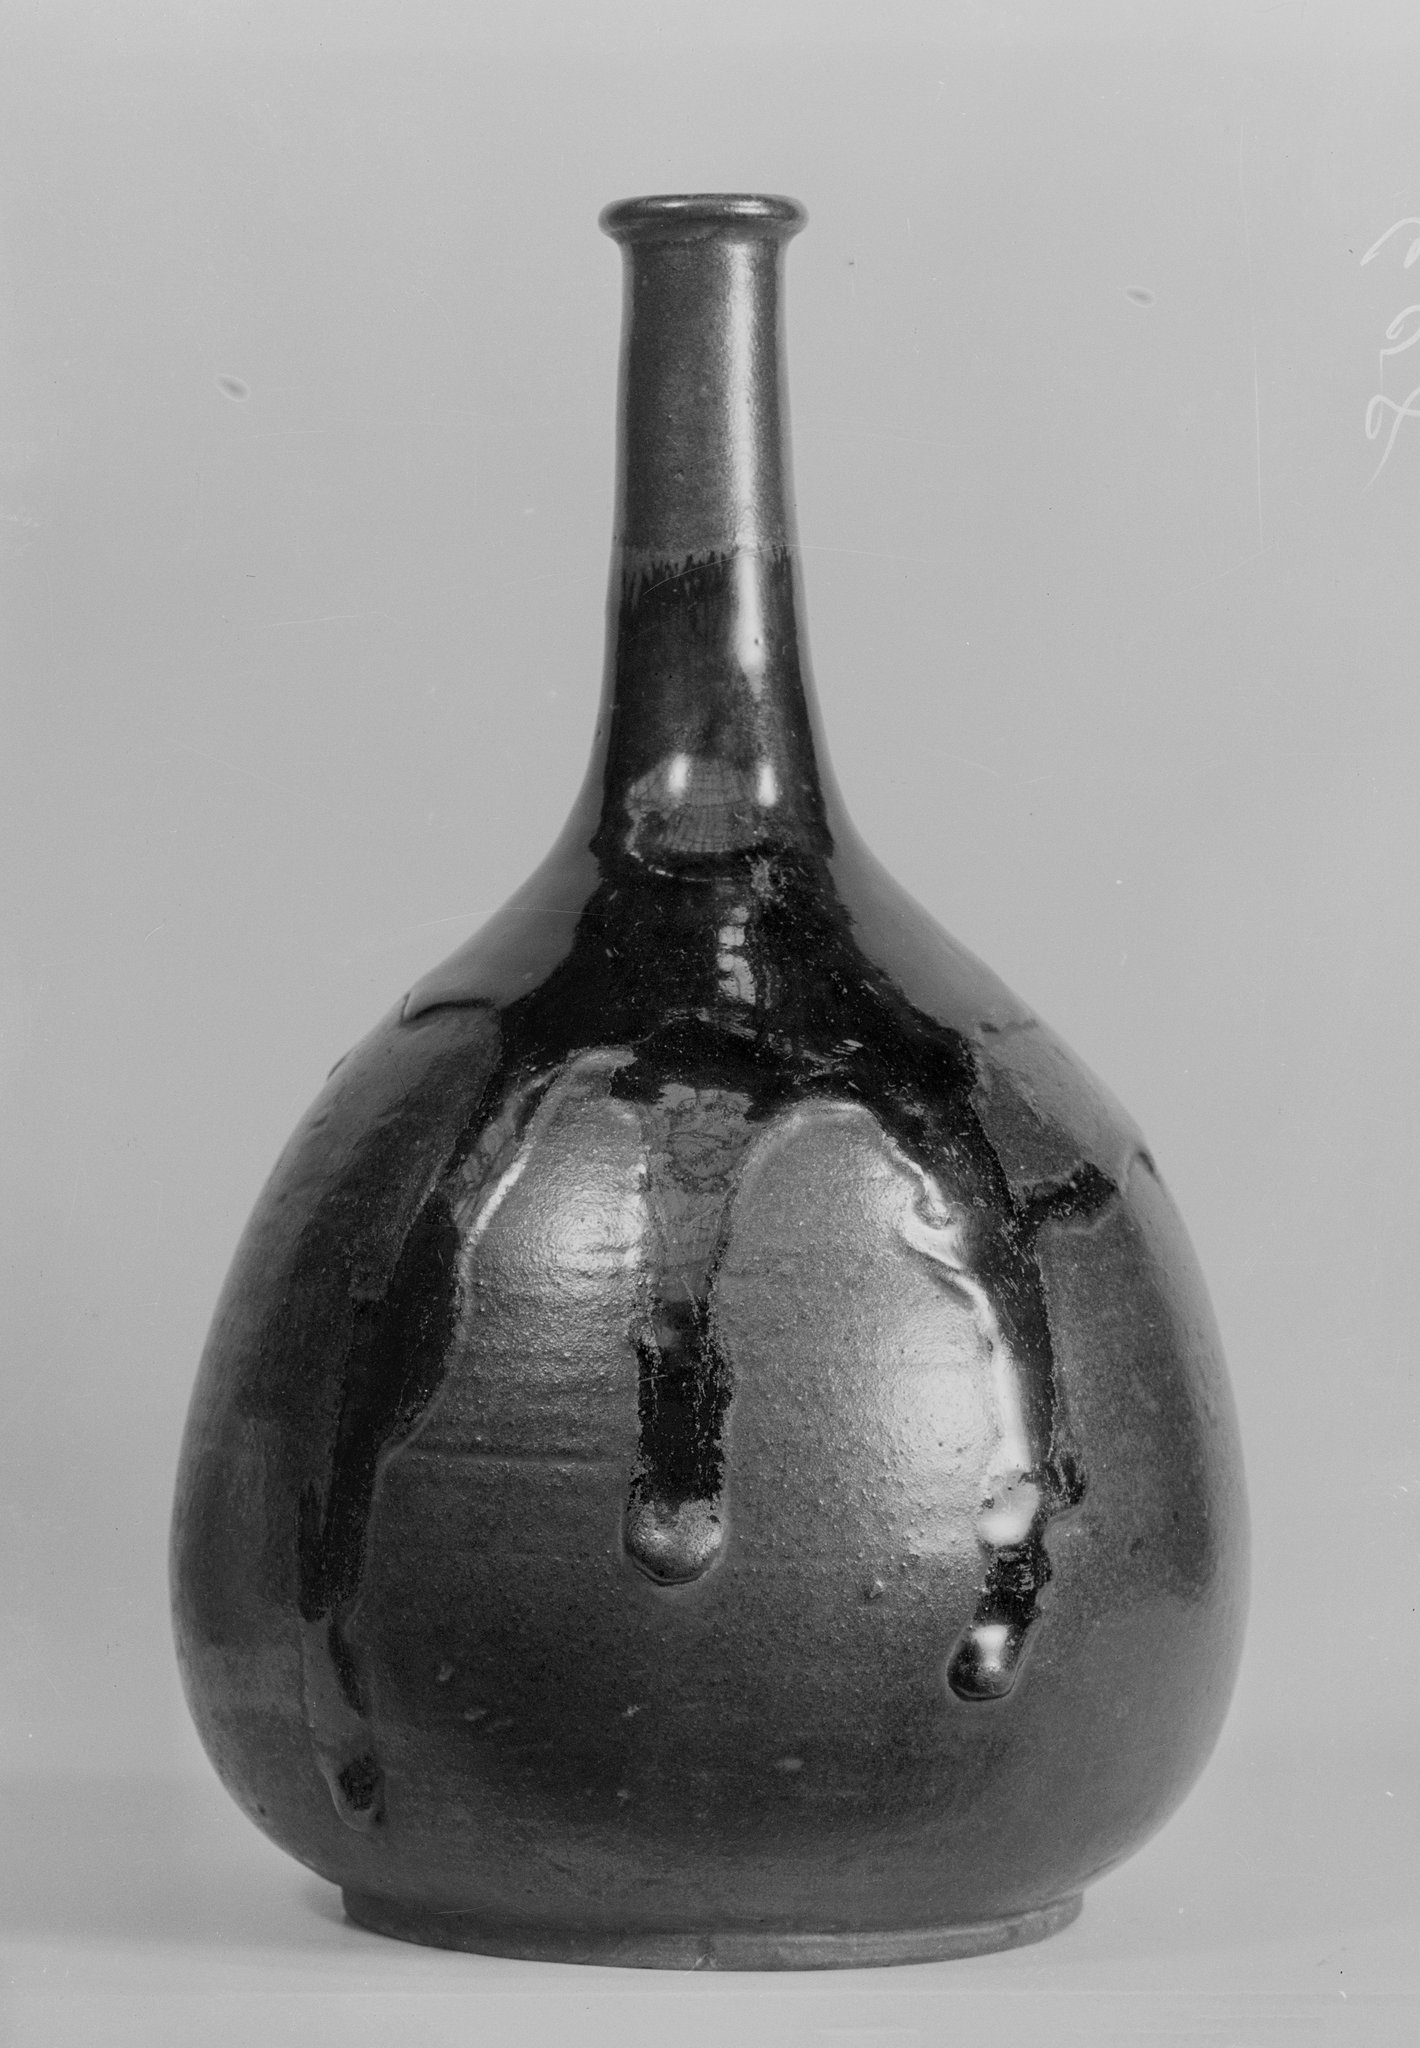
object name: bottle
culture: japanese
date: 1630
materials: clay, glaze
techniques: overglaze